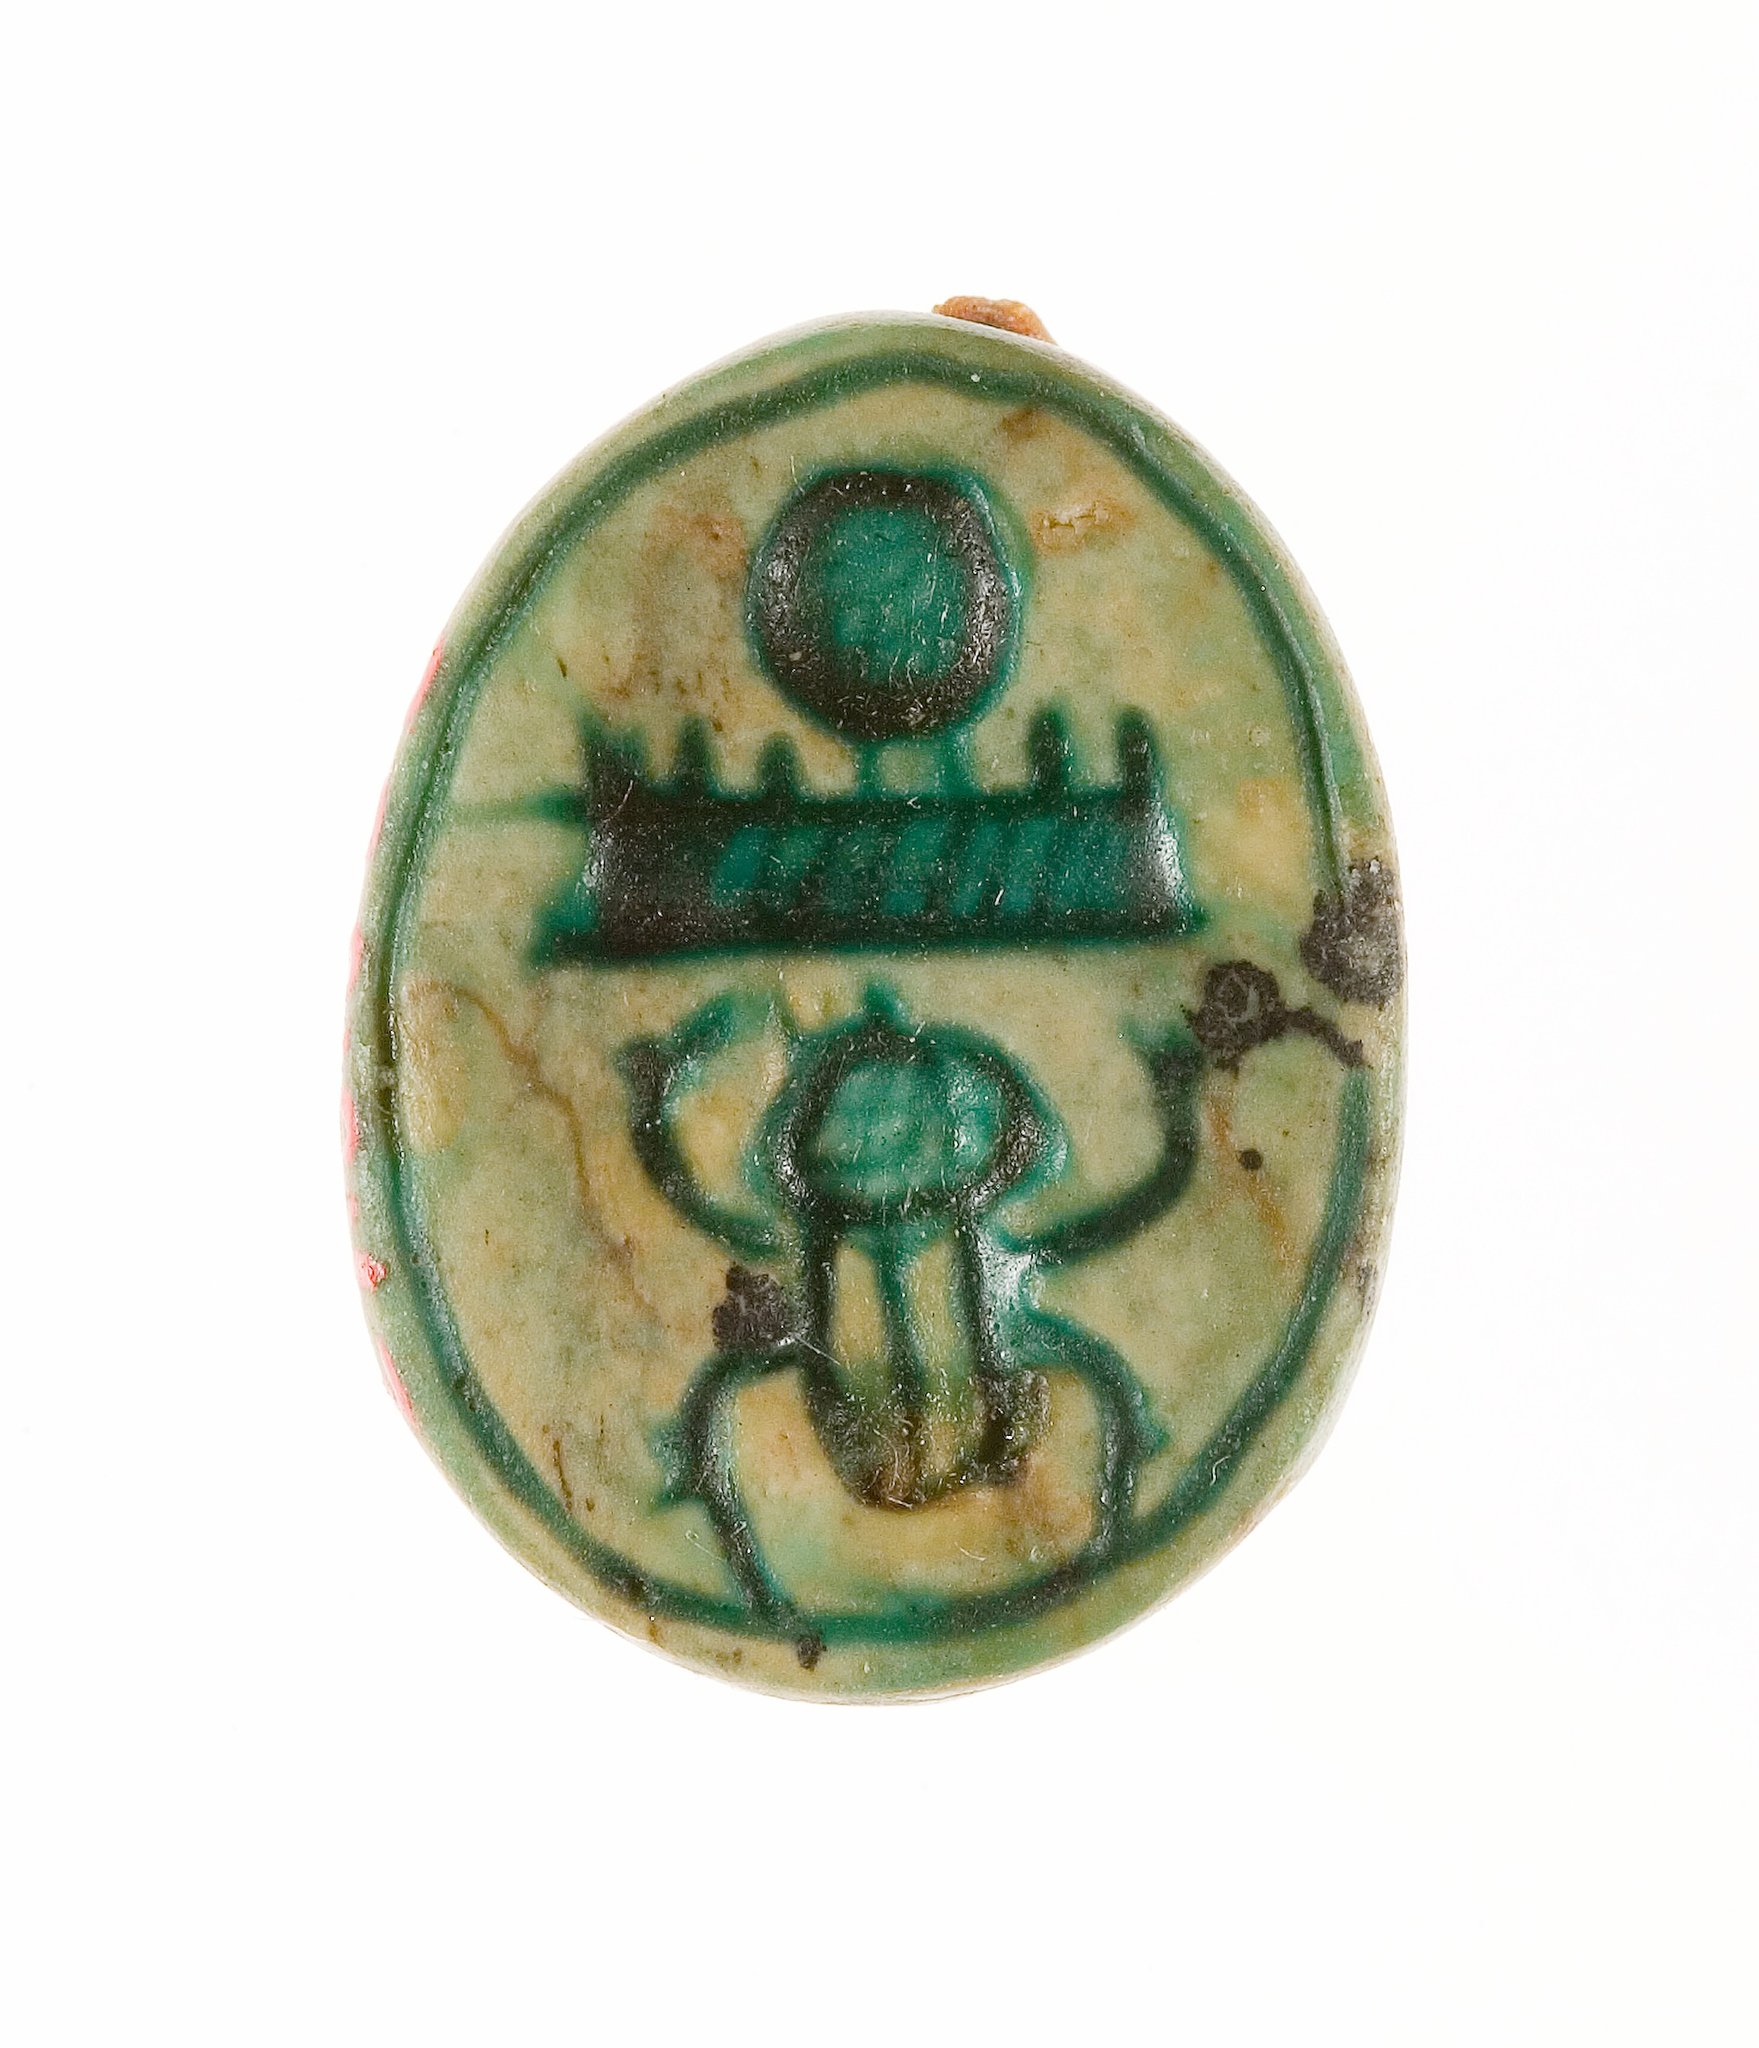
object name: scarab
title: Scarab Inscribed with the Throne Name of Thutmose III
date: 1479-1458 BCE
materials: stone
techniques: glazing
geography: egypt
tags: hieroglyphs,scarabs